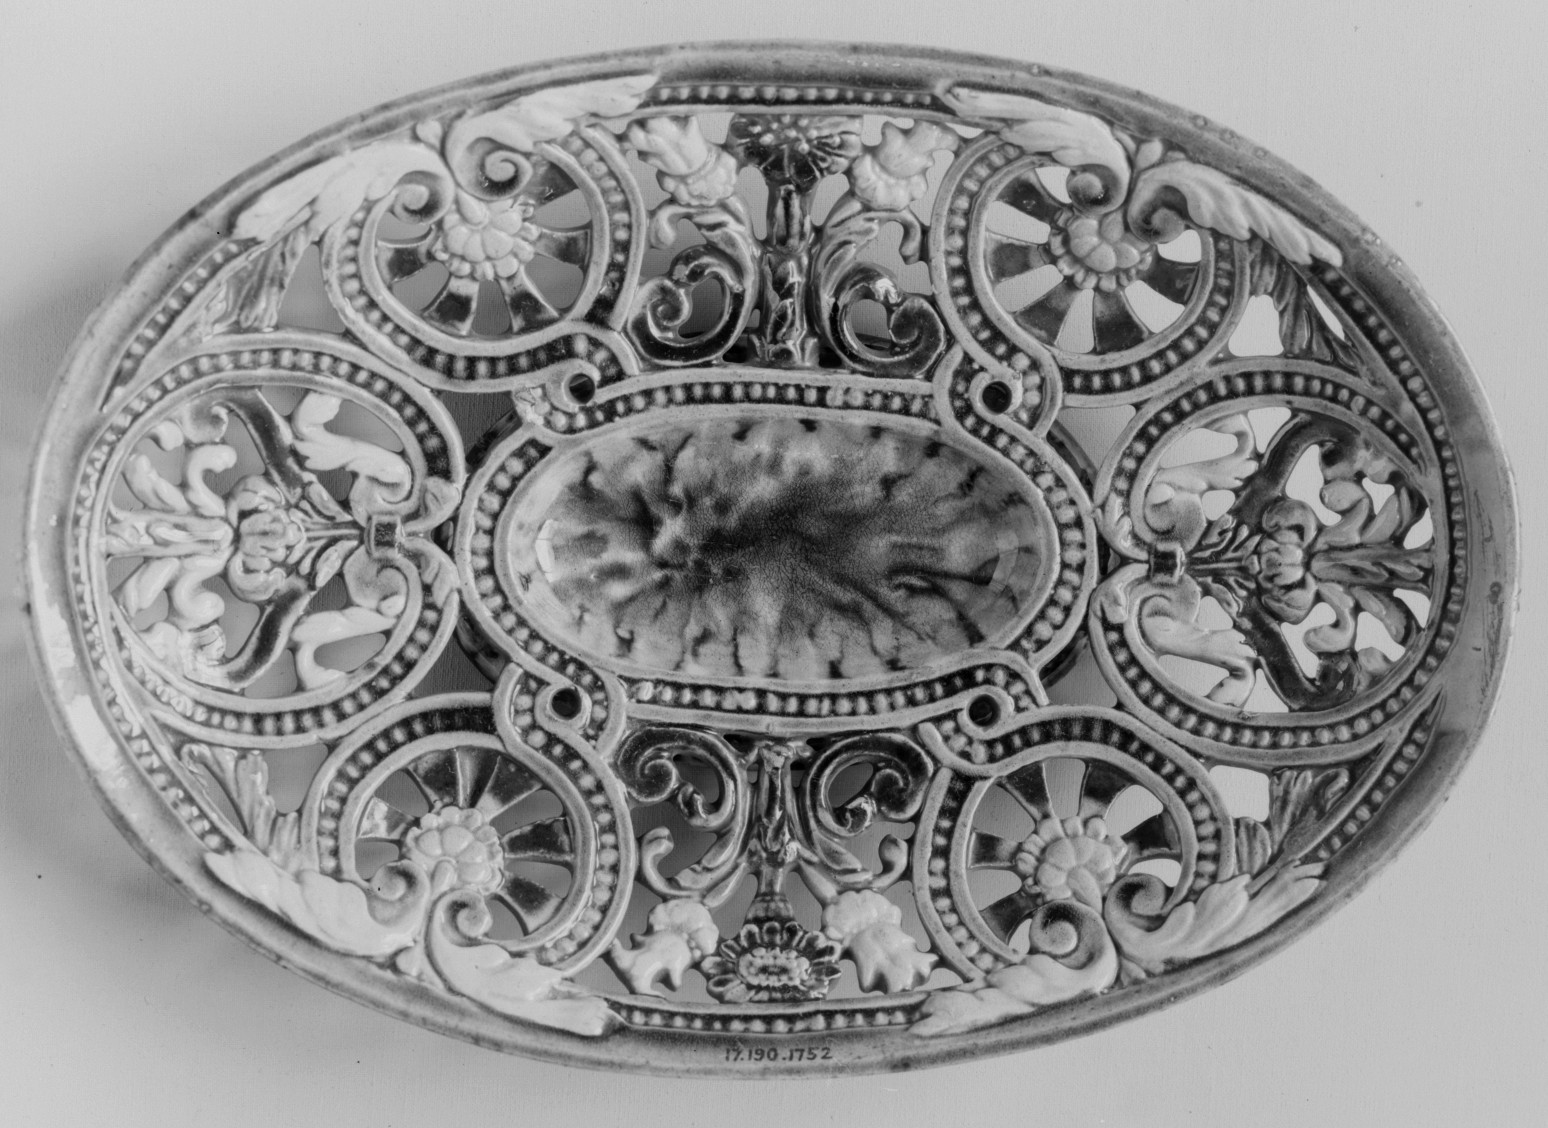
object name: dish on foot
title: Dish on a low foot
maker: bernard palissy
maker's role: maker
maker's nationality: french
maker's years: 1510-1590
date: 1551-1600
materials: earthenware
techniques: glazing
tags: flowers